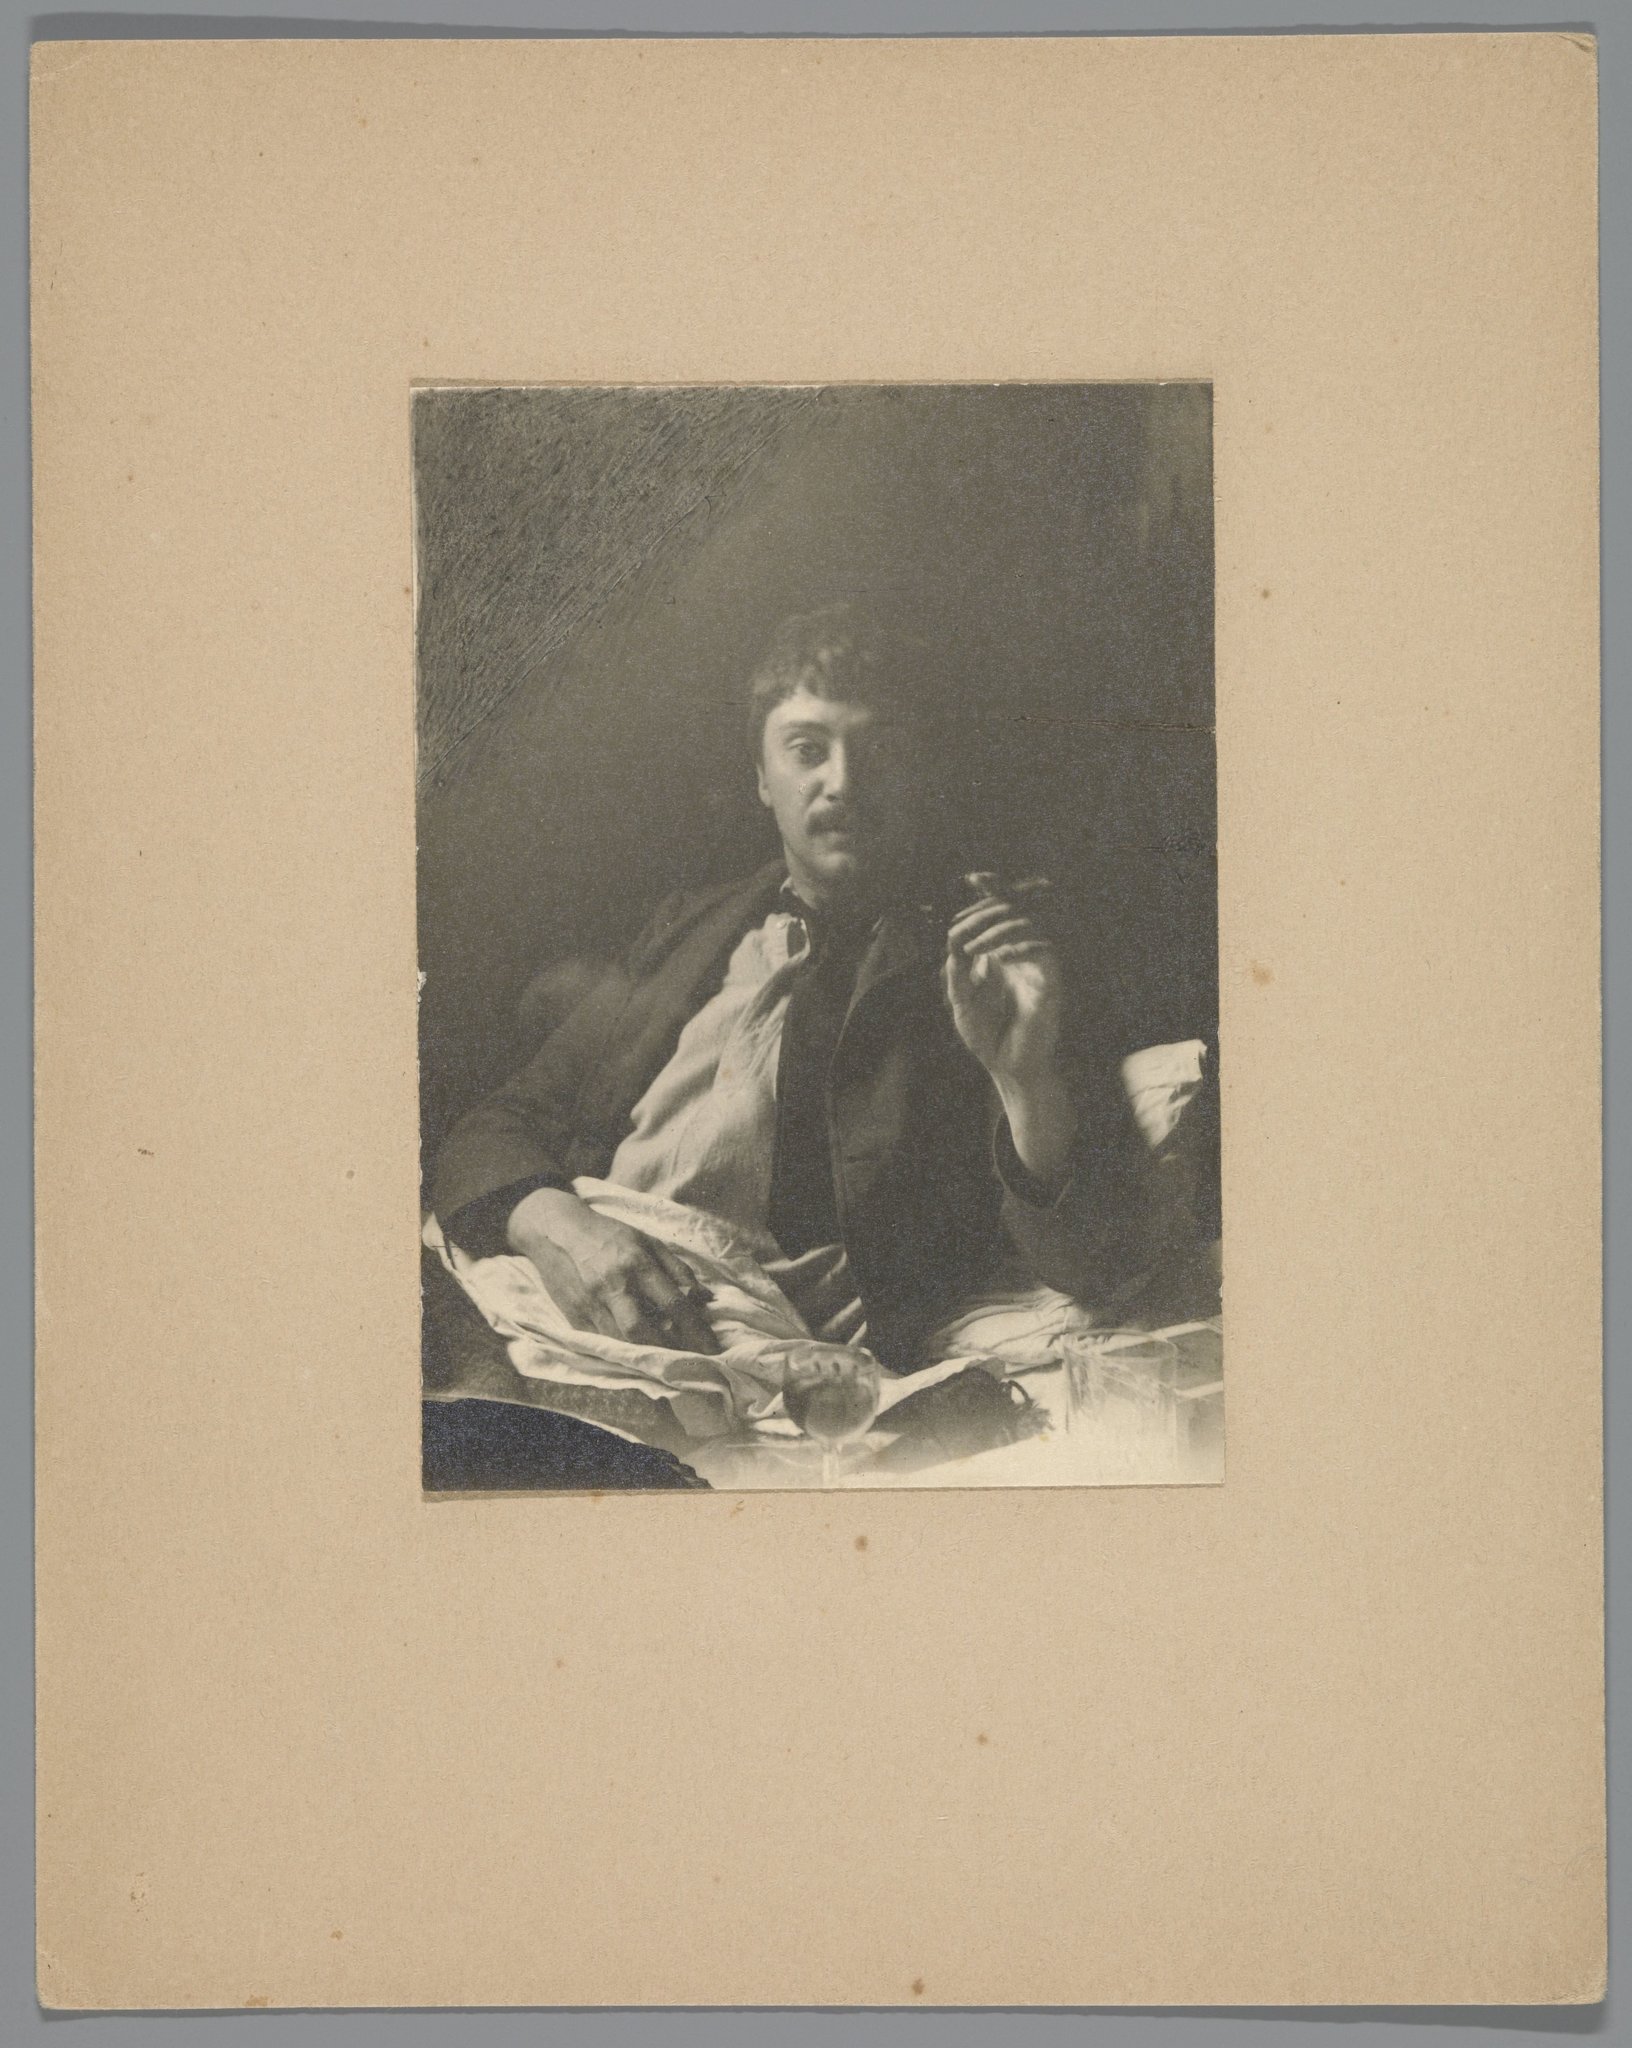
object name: photograph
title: Willem Witsen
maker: Anonymous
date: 1860-1915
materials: paper, photographic support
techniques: gelatin silver print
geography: amsterdam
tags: amsterdam, painter, print maker, draughtsman, willem witsen